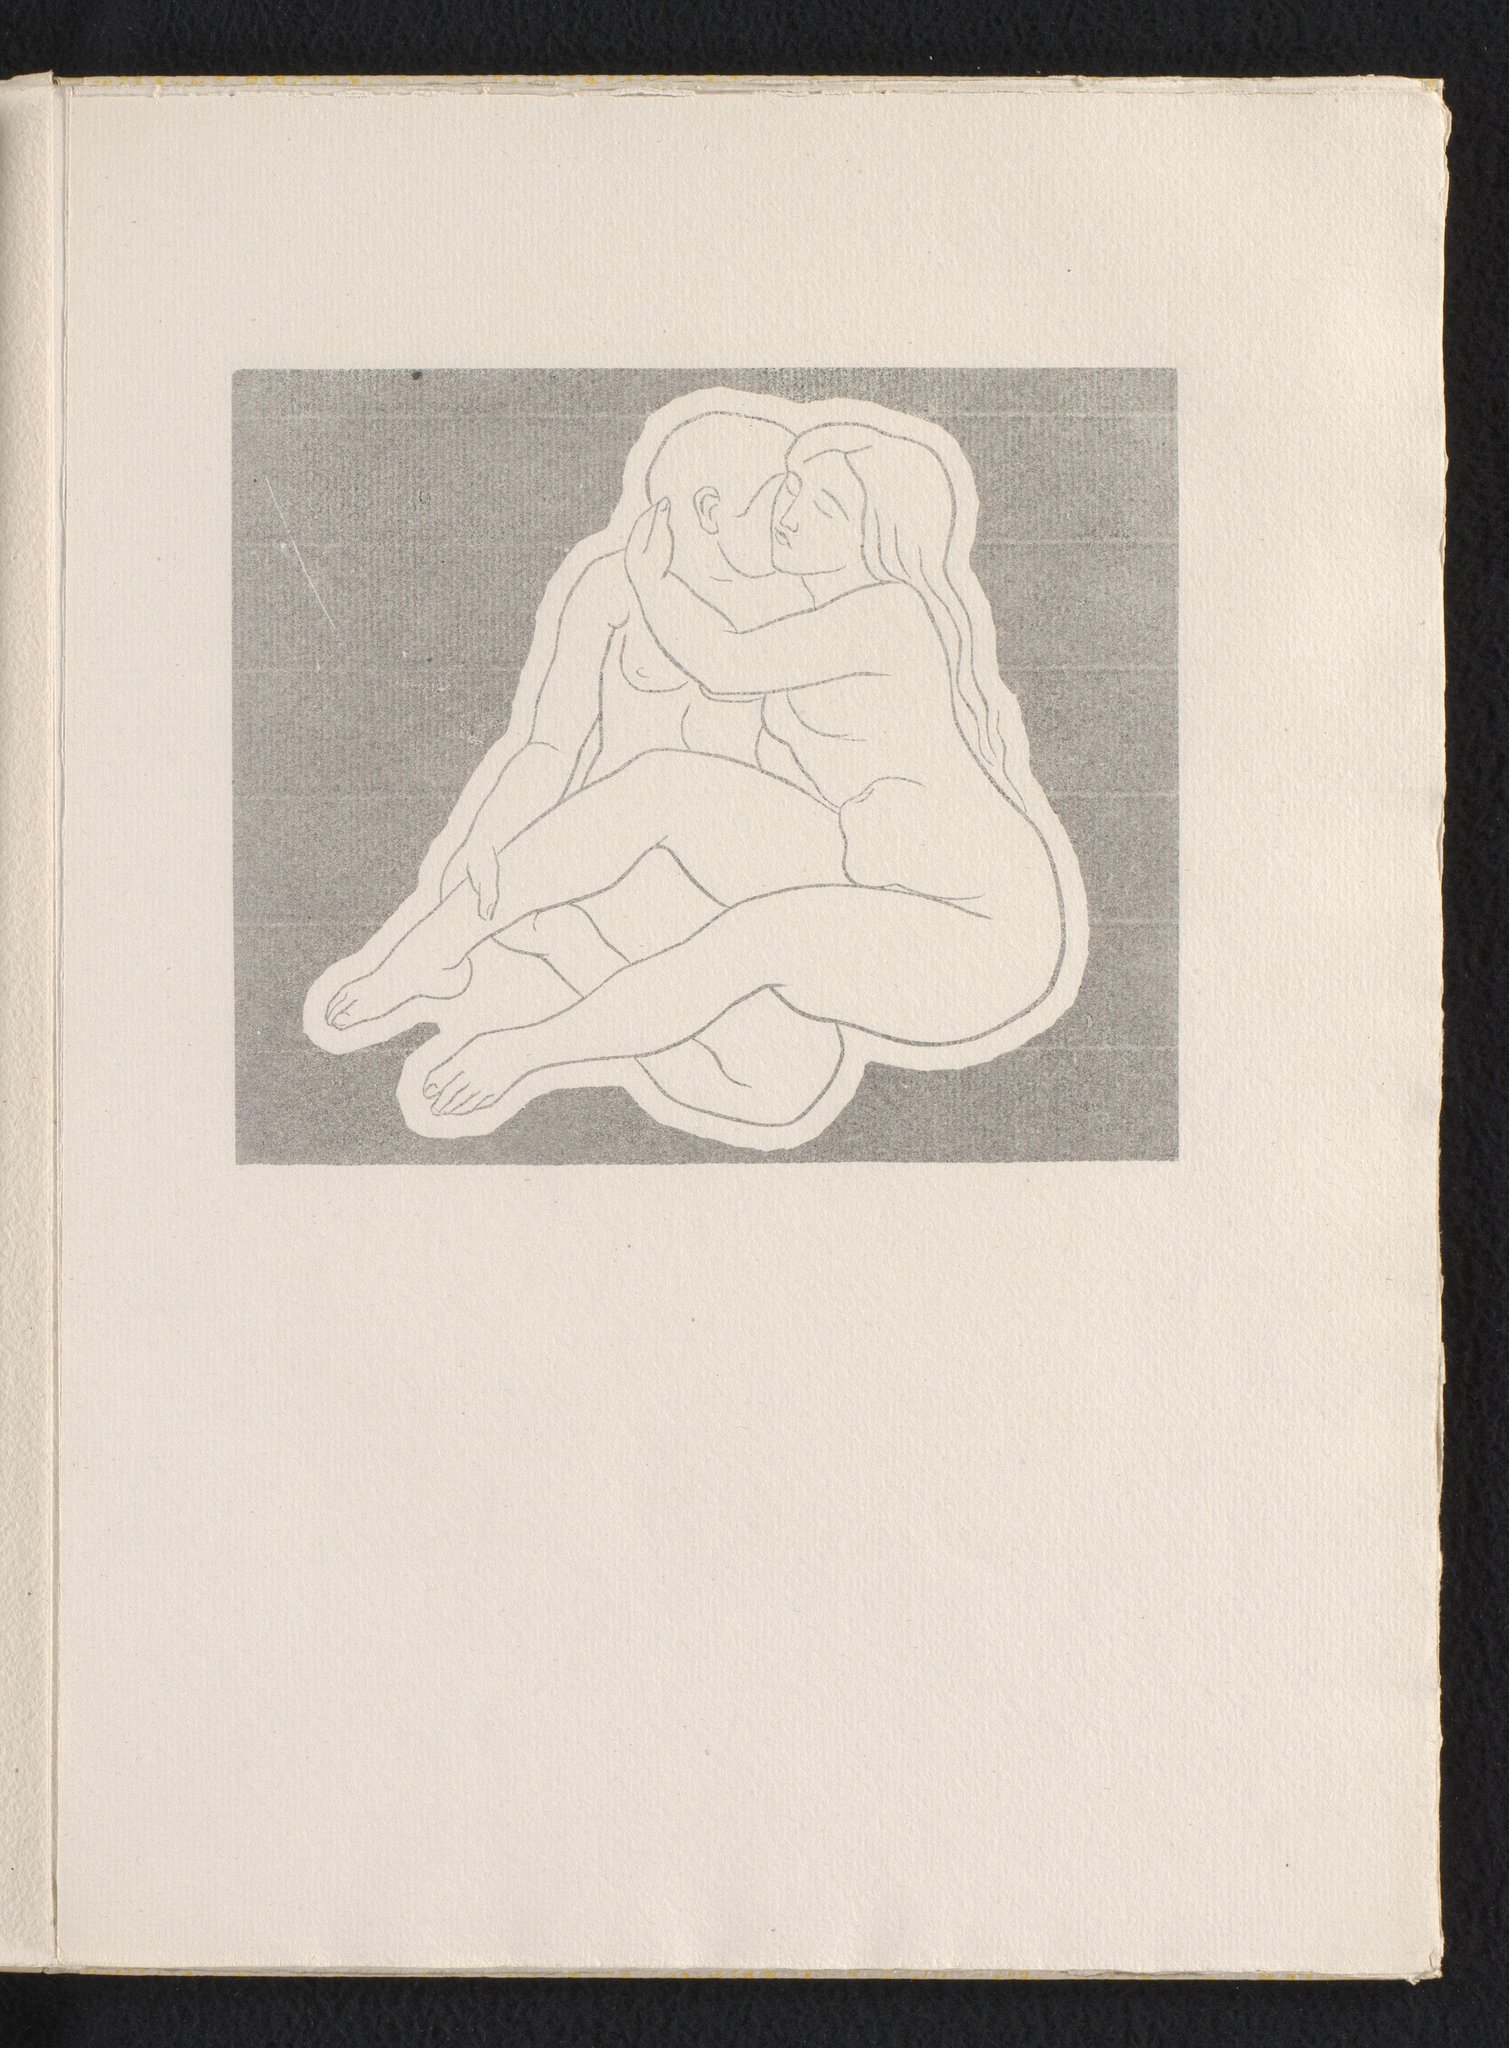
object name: print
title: Zittend naakt koppel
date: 1935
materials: paper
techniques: woodcut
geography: lausanne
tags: woman (showing herself) undressed, quasi-nude, couple of lovers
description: Prent in: Ovidius Naso, Publius. L'art d'aimer. [Vertaald uit het Latijn door] Henri Bornecque. Parijs/Lausanne: Les frères Gonin, 1935, na p. 108.